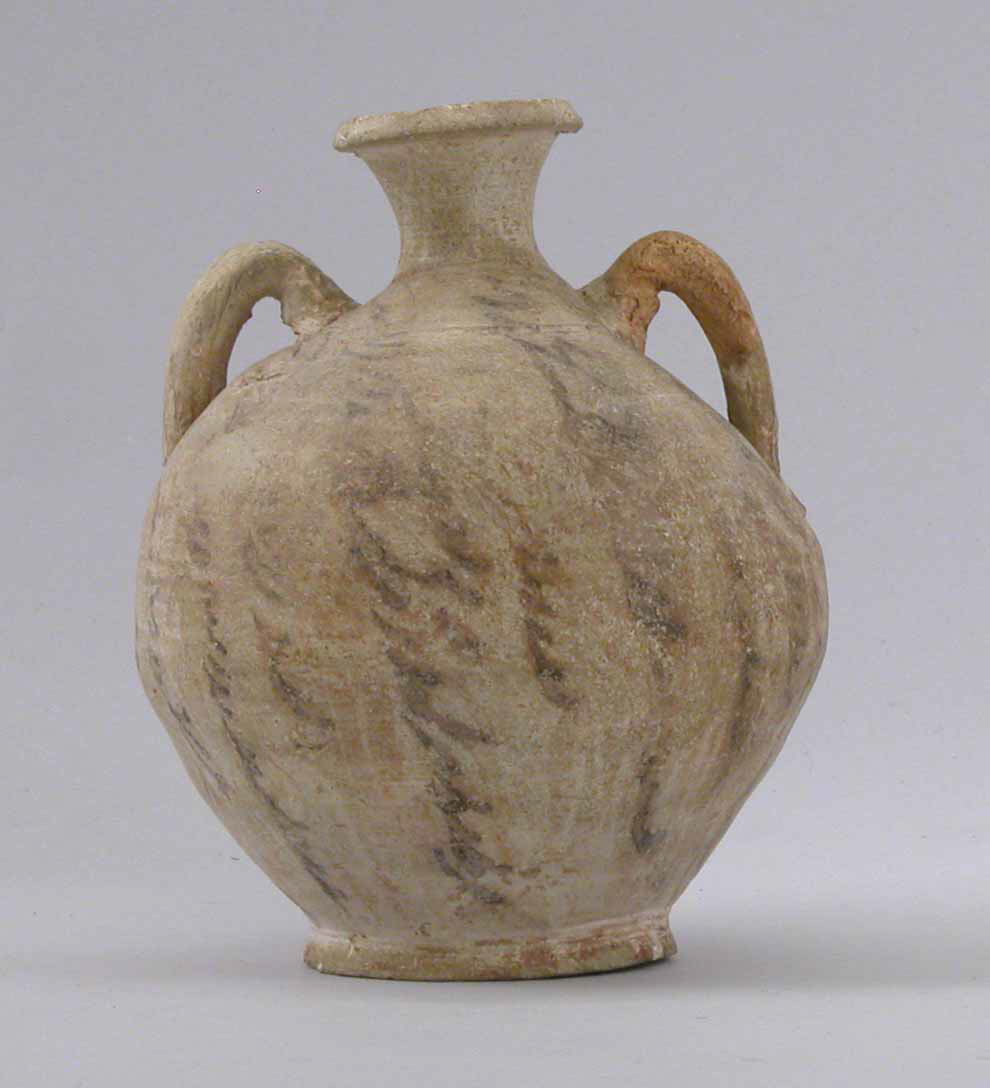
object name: jar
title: Jar with Writing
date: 701-1000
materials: earthenware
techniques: painting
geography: iran